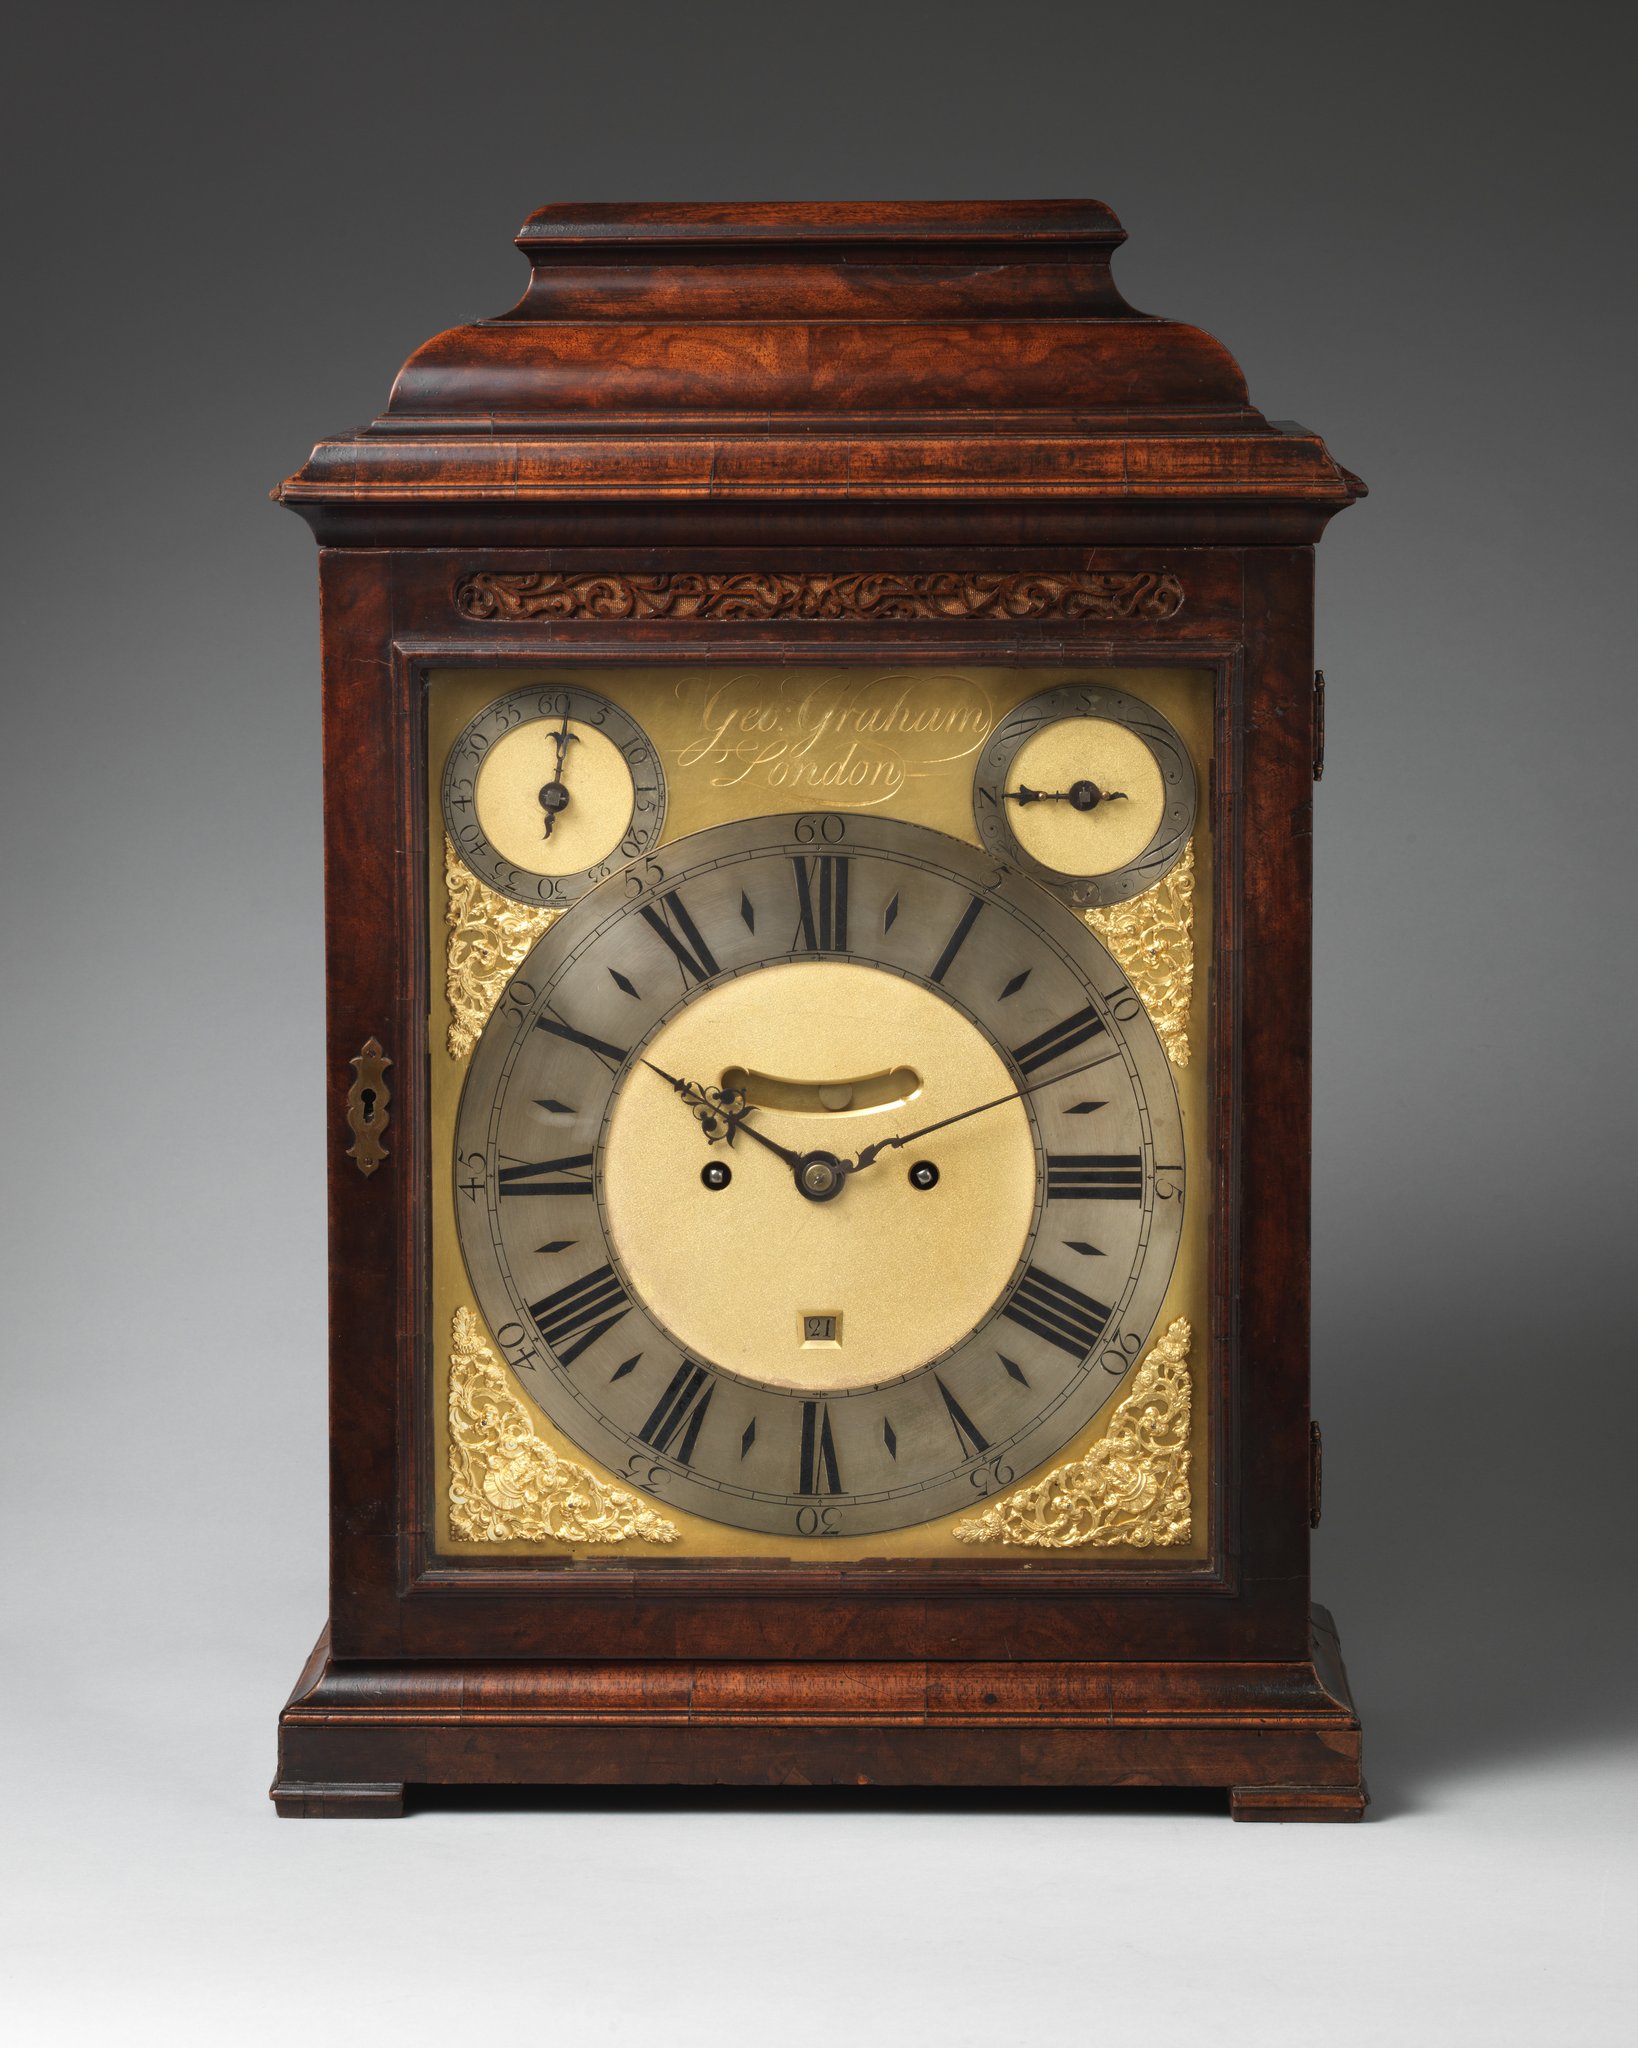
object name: table or bracket clock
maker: george graham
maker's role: maker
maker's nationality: british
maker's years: 1673-1751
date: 1720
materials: brass, wood, steel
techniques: gilding, silvered, veneering